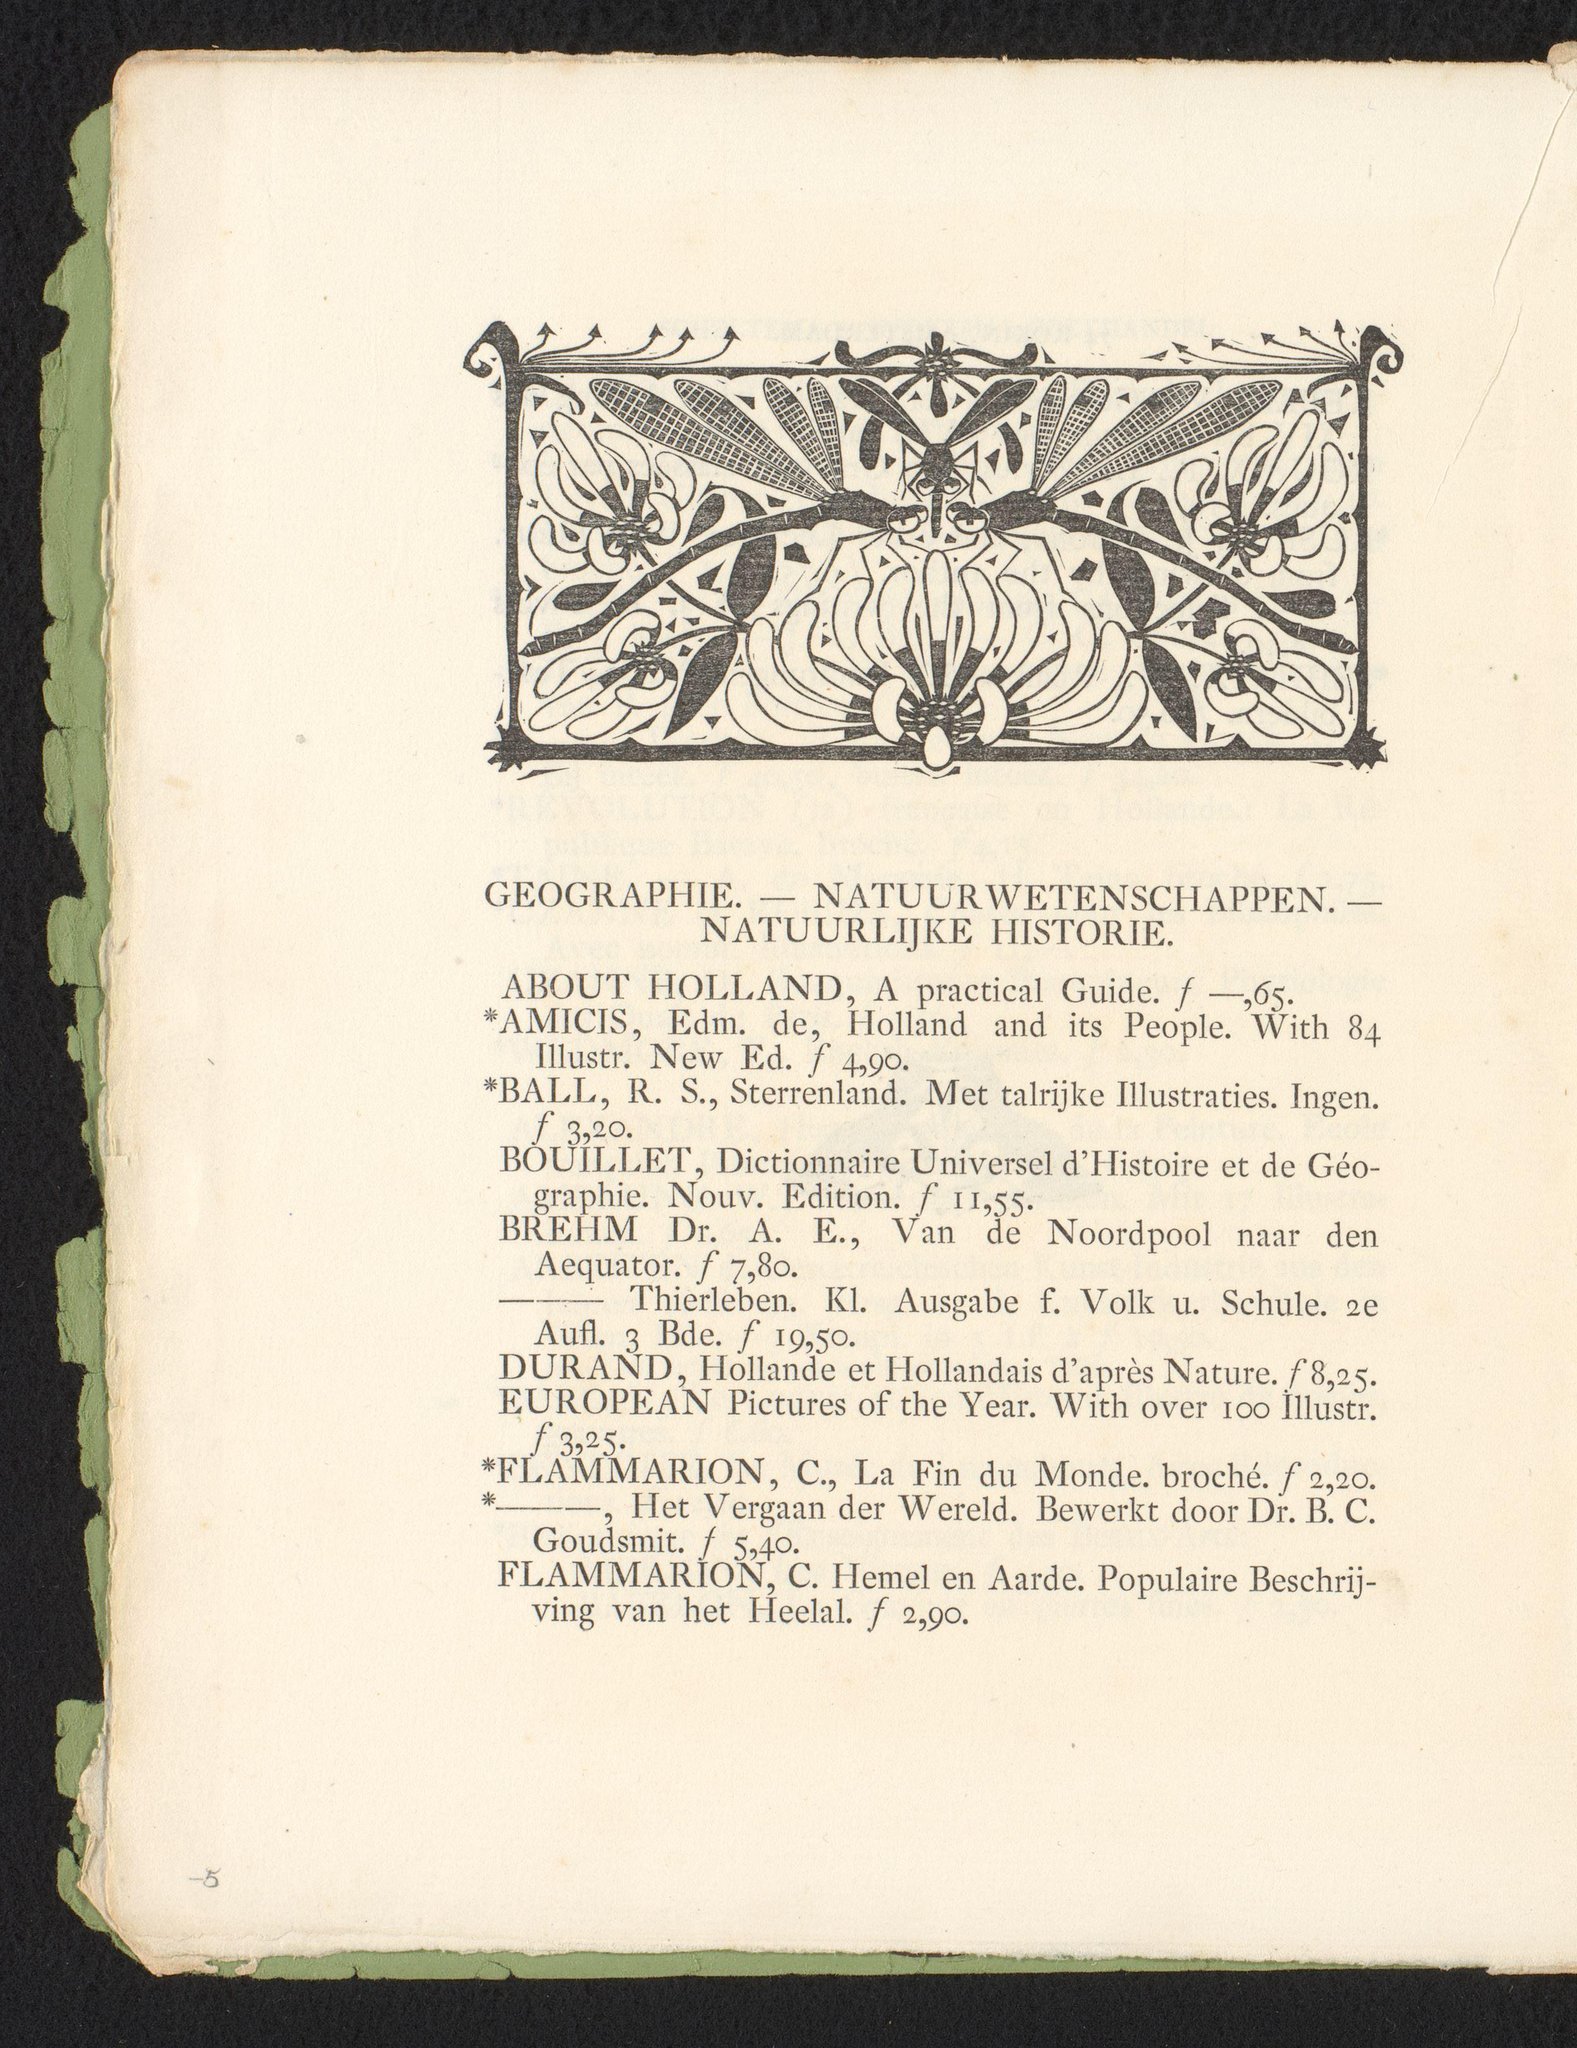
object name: print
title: Titelhoofd met libellen en mug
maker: gerrit willem dijsselhof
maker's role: designer, draughtsman, print maker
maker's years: 1866-1924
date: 1893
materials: paper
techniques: letterpress printing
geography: amsterdam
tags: insects: dragon-fly, other ornament derived from animal forms, insects: mosquito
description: Prent uit: Catalogus van handboeken, pracht- en plaatwerken, dicht- en prozabundels en kinderliteratuur (...). Amsterdam: Scheltema & Holkema's Boekhandel, 1894, p. 8. Deze prent werd origineel ontworpen voor: Crane, Walter. Kunst en samenleving. [Vertaald uit het Engels door] Jan Veth. Amsterdam: Scheltema & Holkema's Boekhandel, 1894 [1893], p. 158.